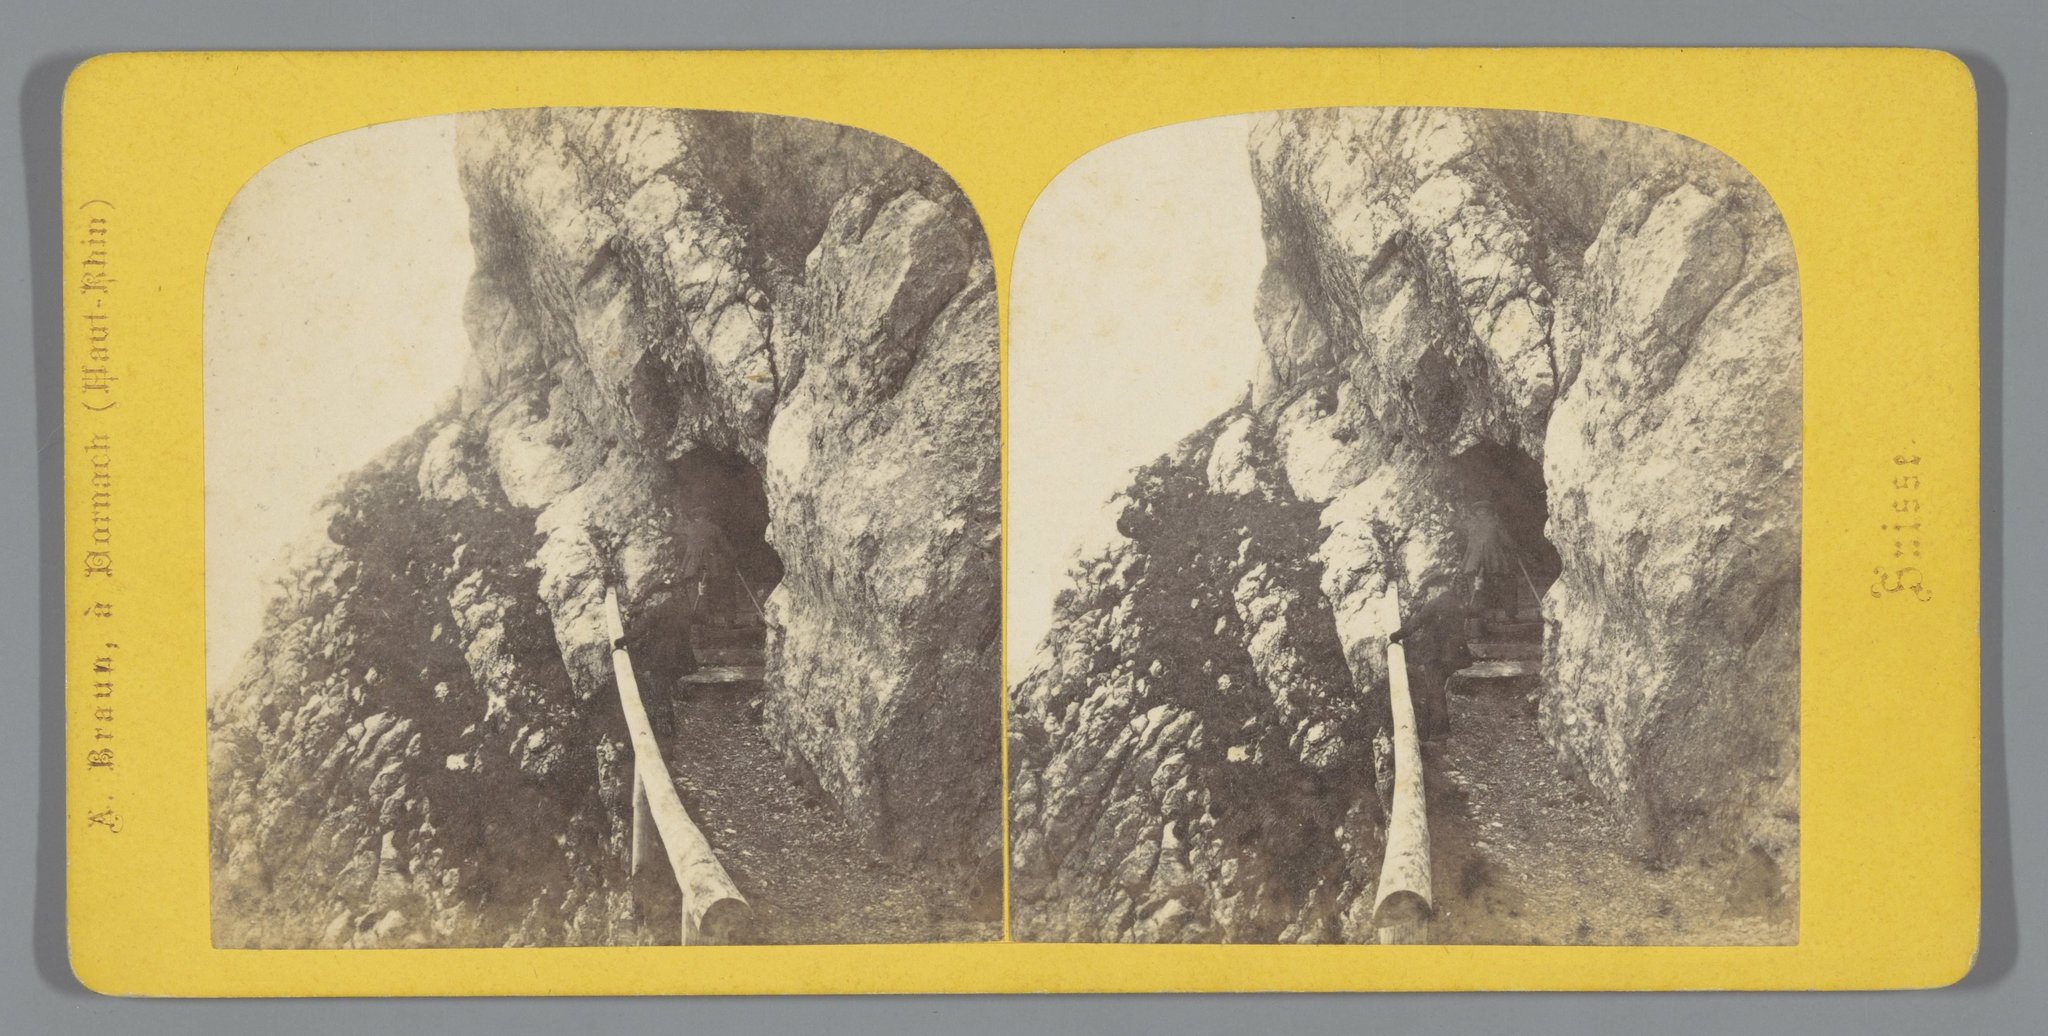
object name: stereograph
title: Suisse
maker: Anonymous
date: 1879-1889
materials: cardboard, paper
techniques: albumen print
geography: pilatus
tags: mountain climbing, mountaineering, underground road, tunnel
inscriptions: number: ‘No 4627.’